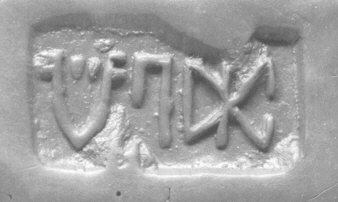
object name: stamp seal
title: Bar-shaped rectangular plaque seal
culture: indus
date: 3000-2001 BCE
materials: stone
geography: indus valley